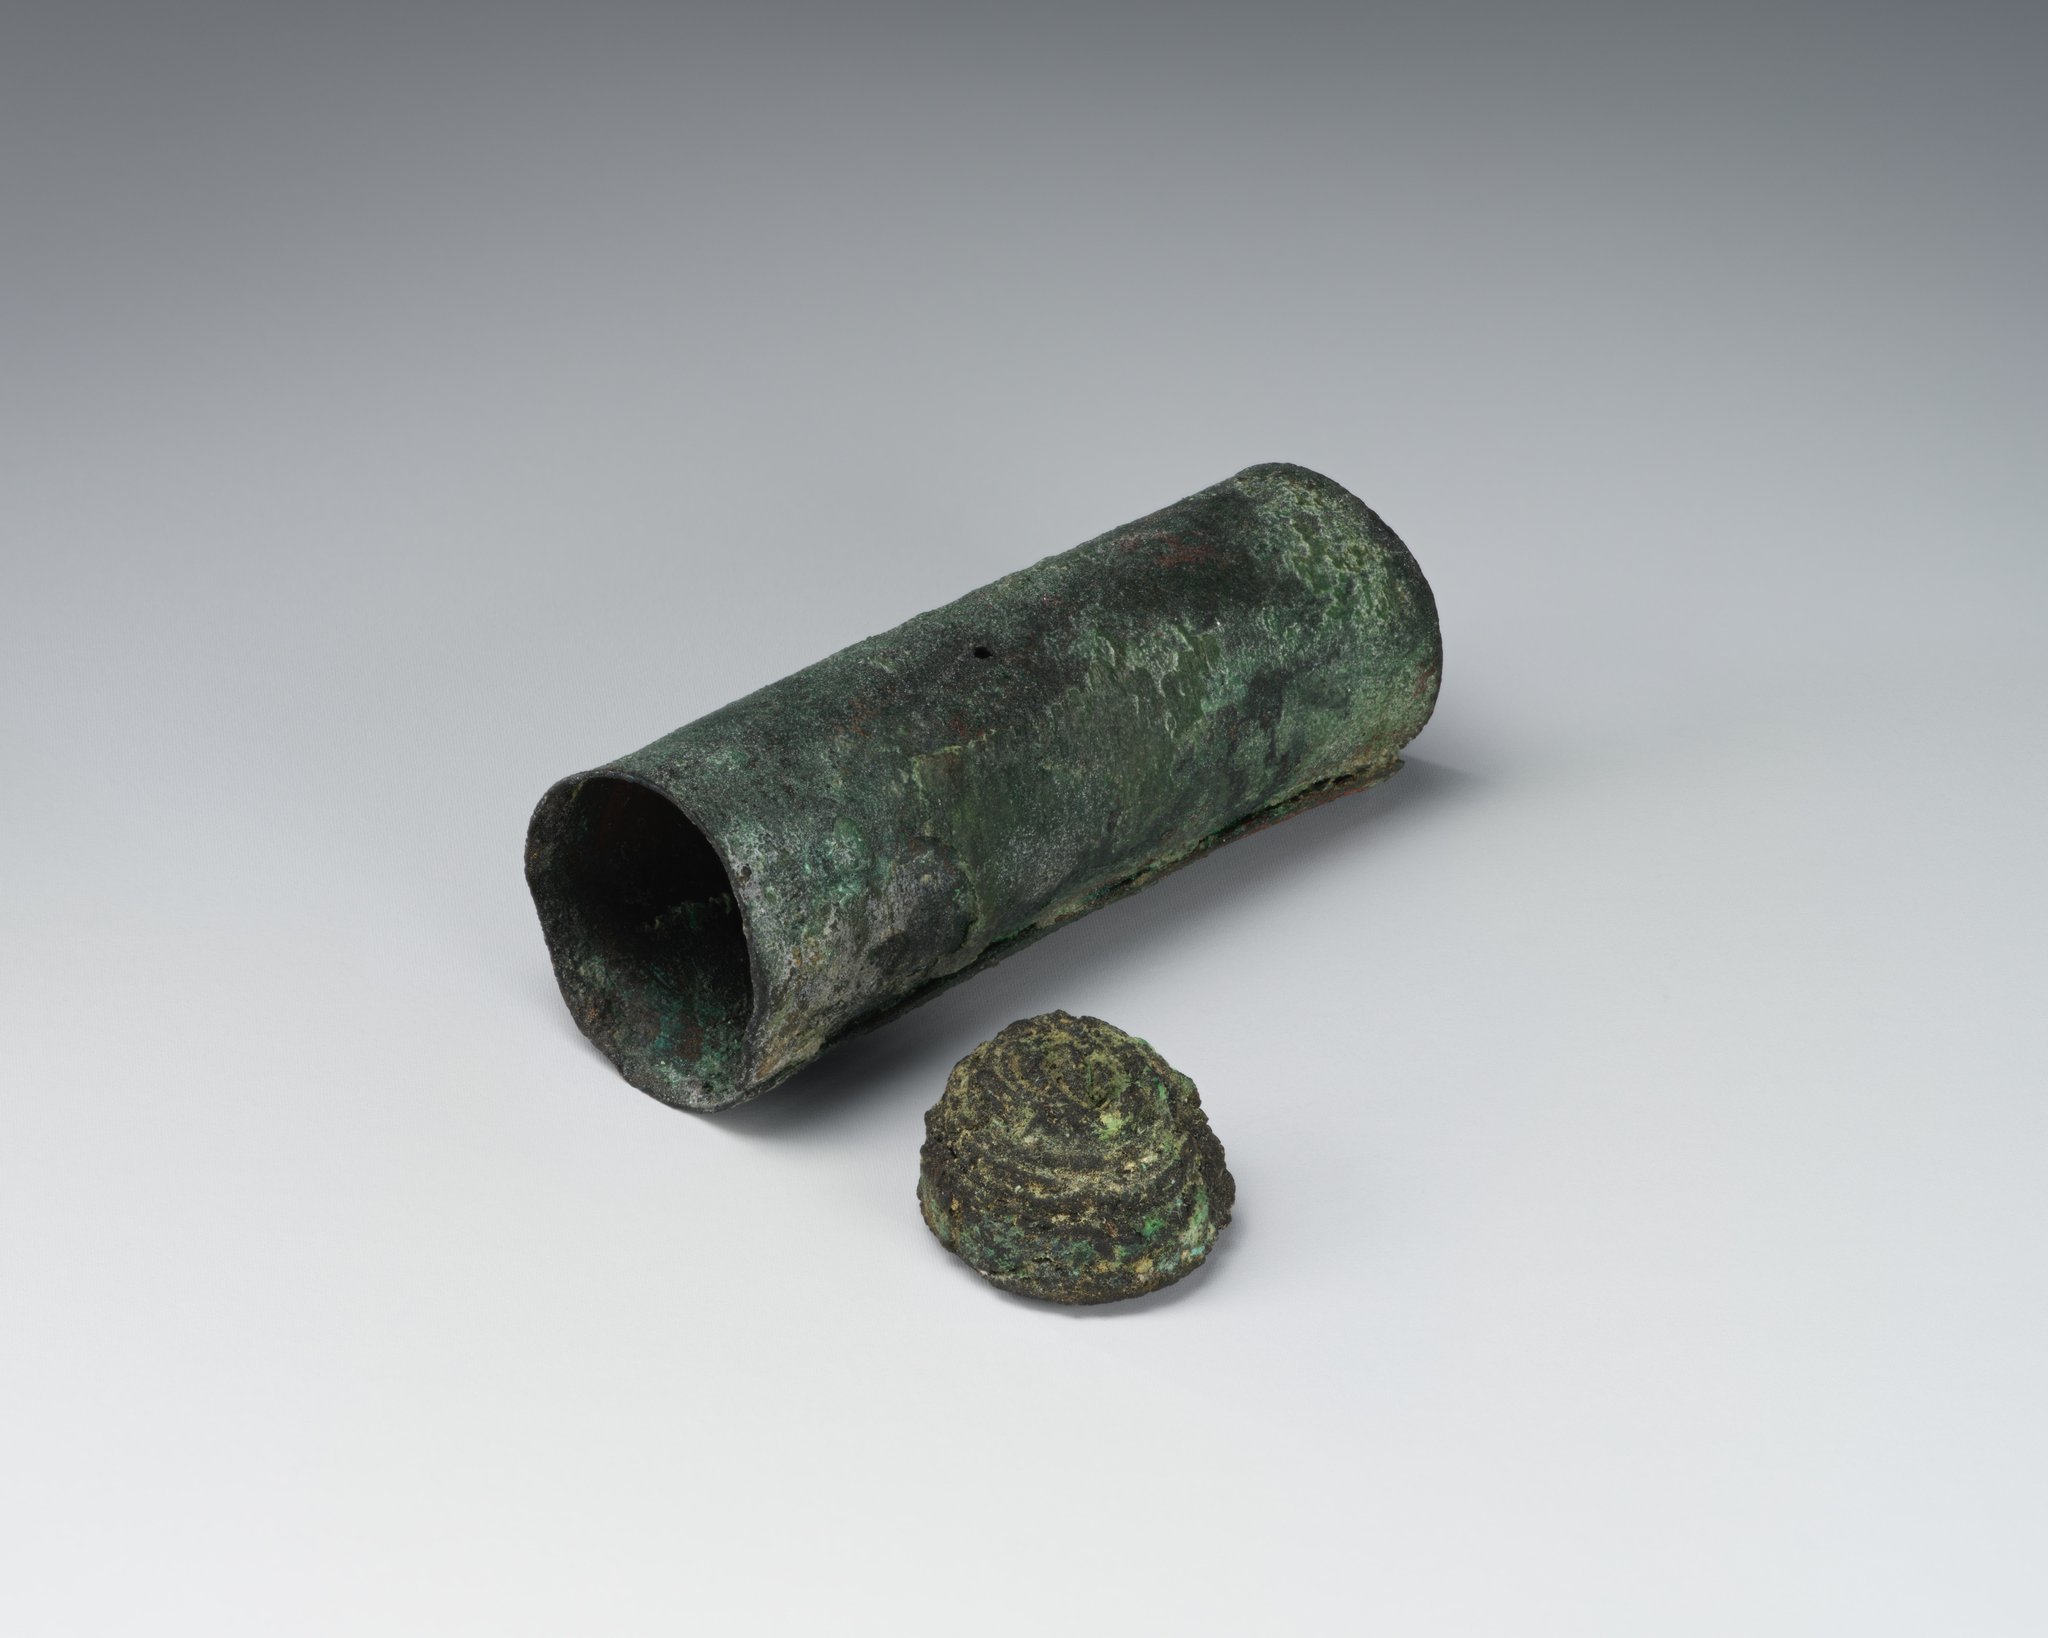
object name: amulet case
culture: sasanian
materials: bronze, copper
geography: mesopotamia